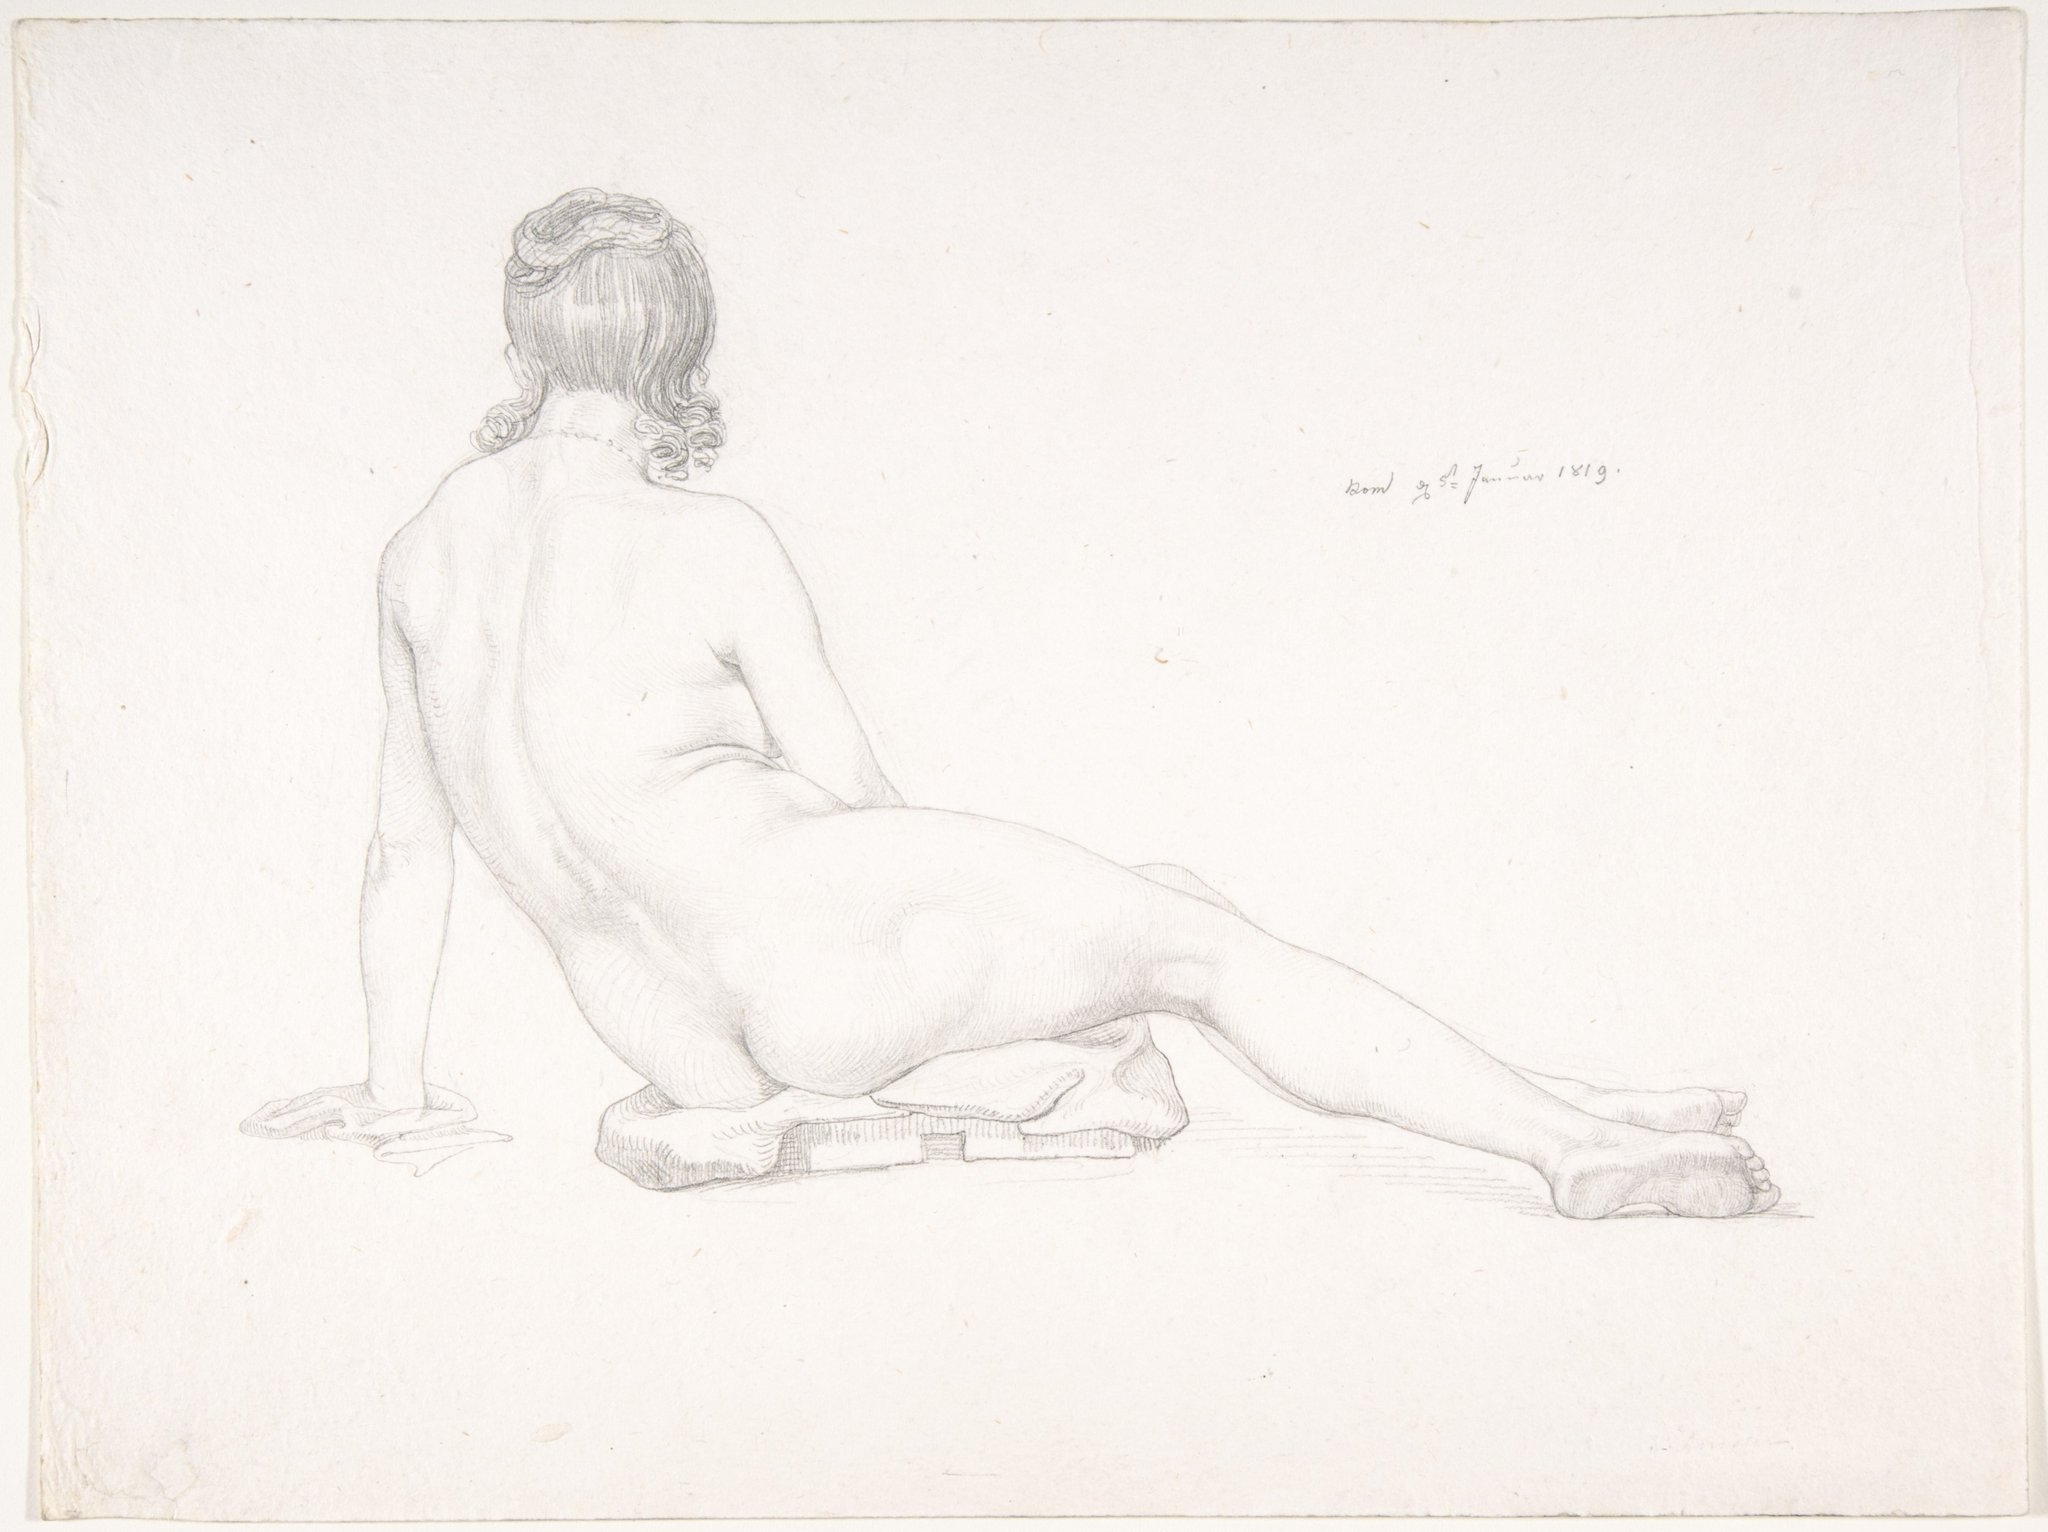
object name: drawing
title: Seated Female Nude Seen from the Back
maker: samuel amsler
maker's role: artist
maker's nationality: german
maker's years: 1791-1849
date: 1819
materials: graphite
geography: germany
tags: female nudes